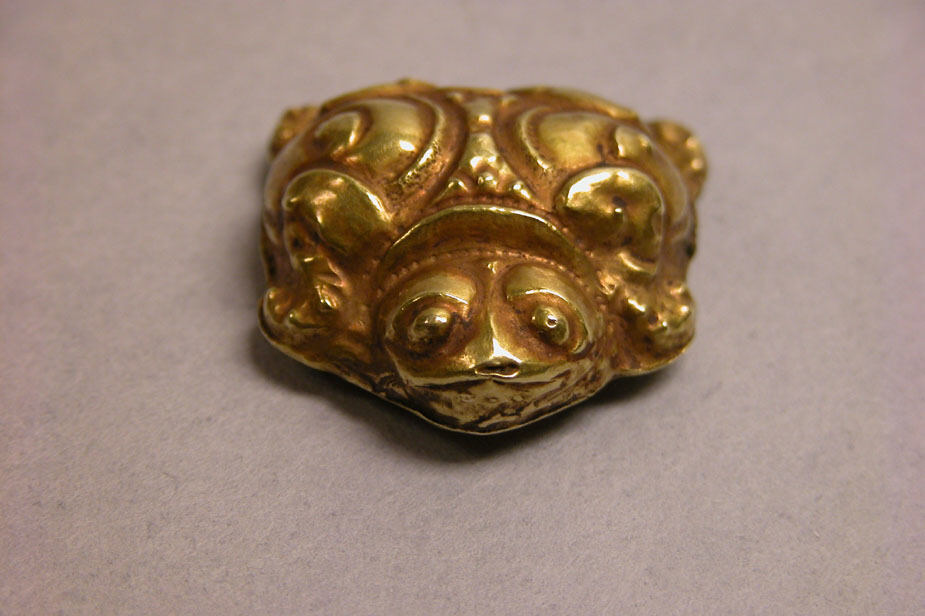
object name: ornament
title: Ornament in the Shape of a Frog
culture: indonesian, javanese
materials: gold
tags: frogs